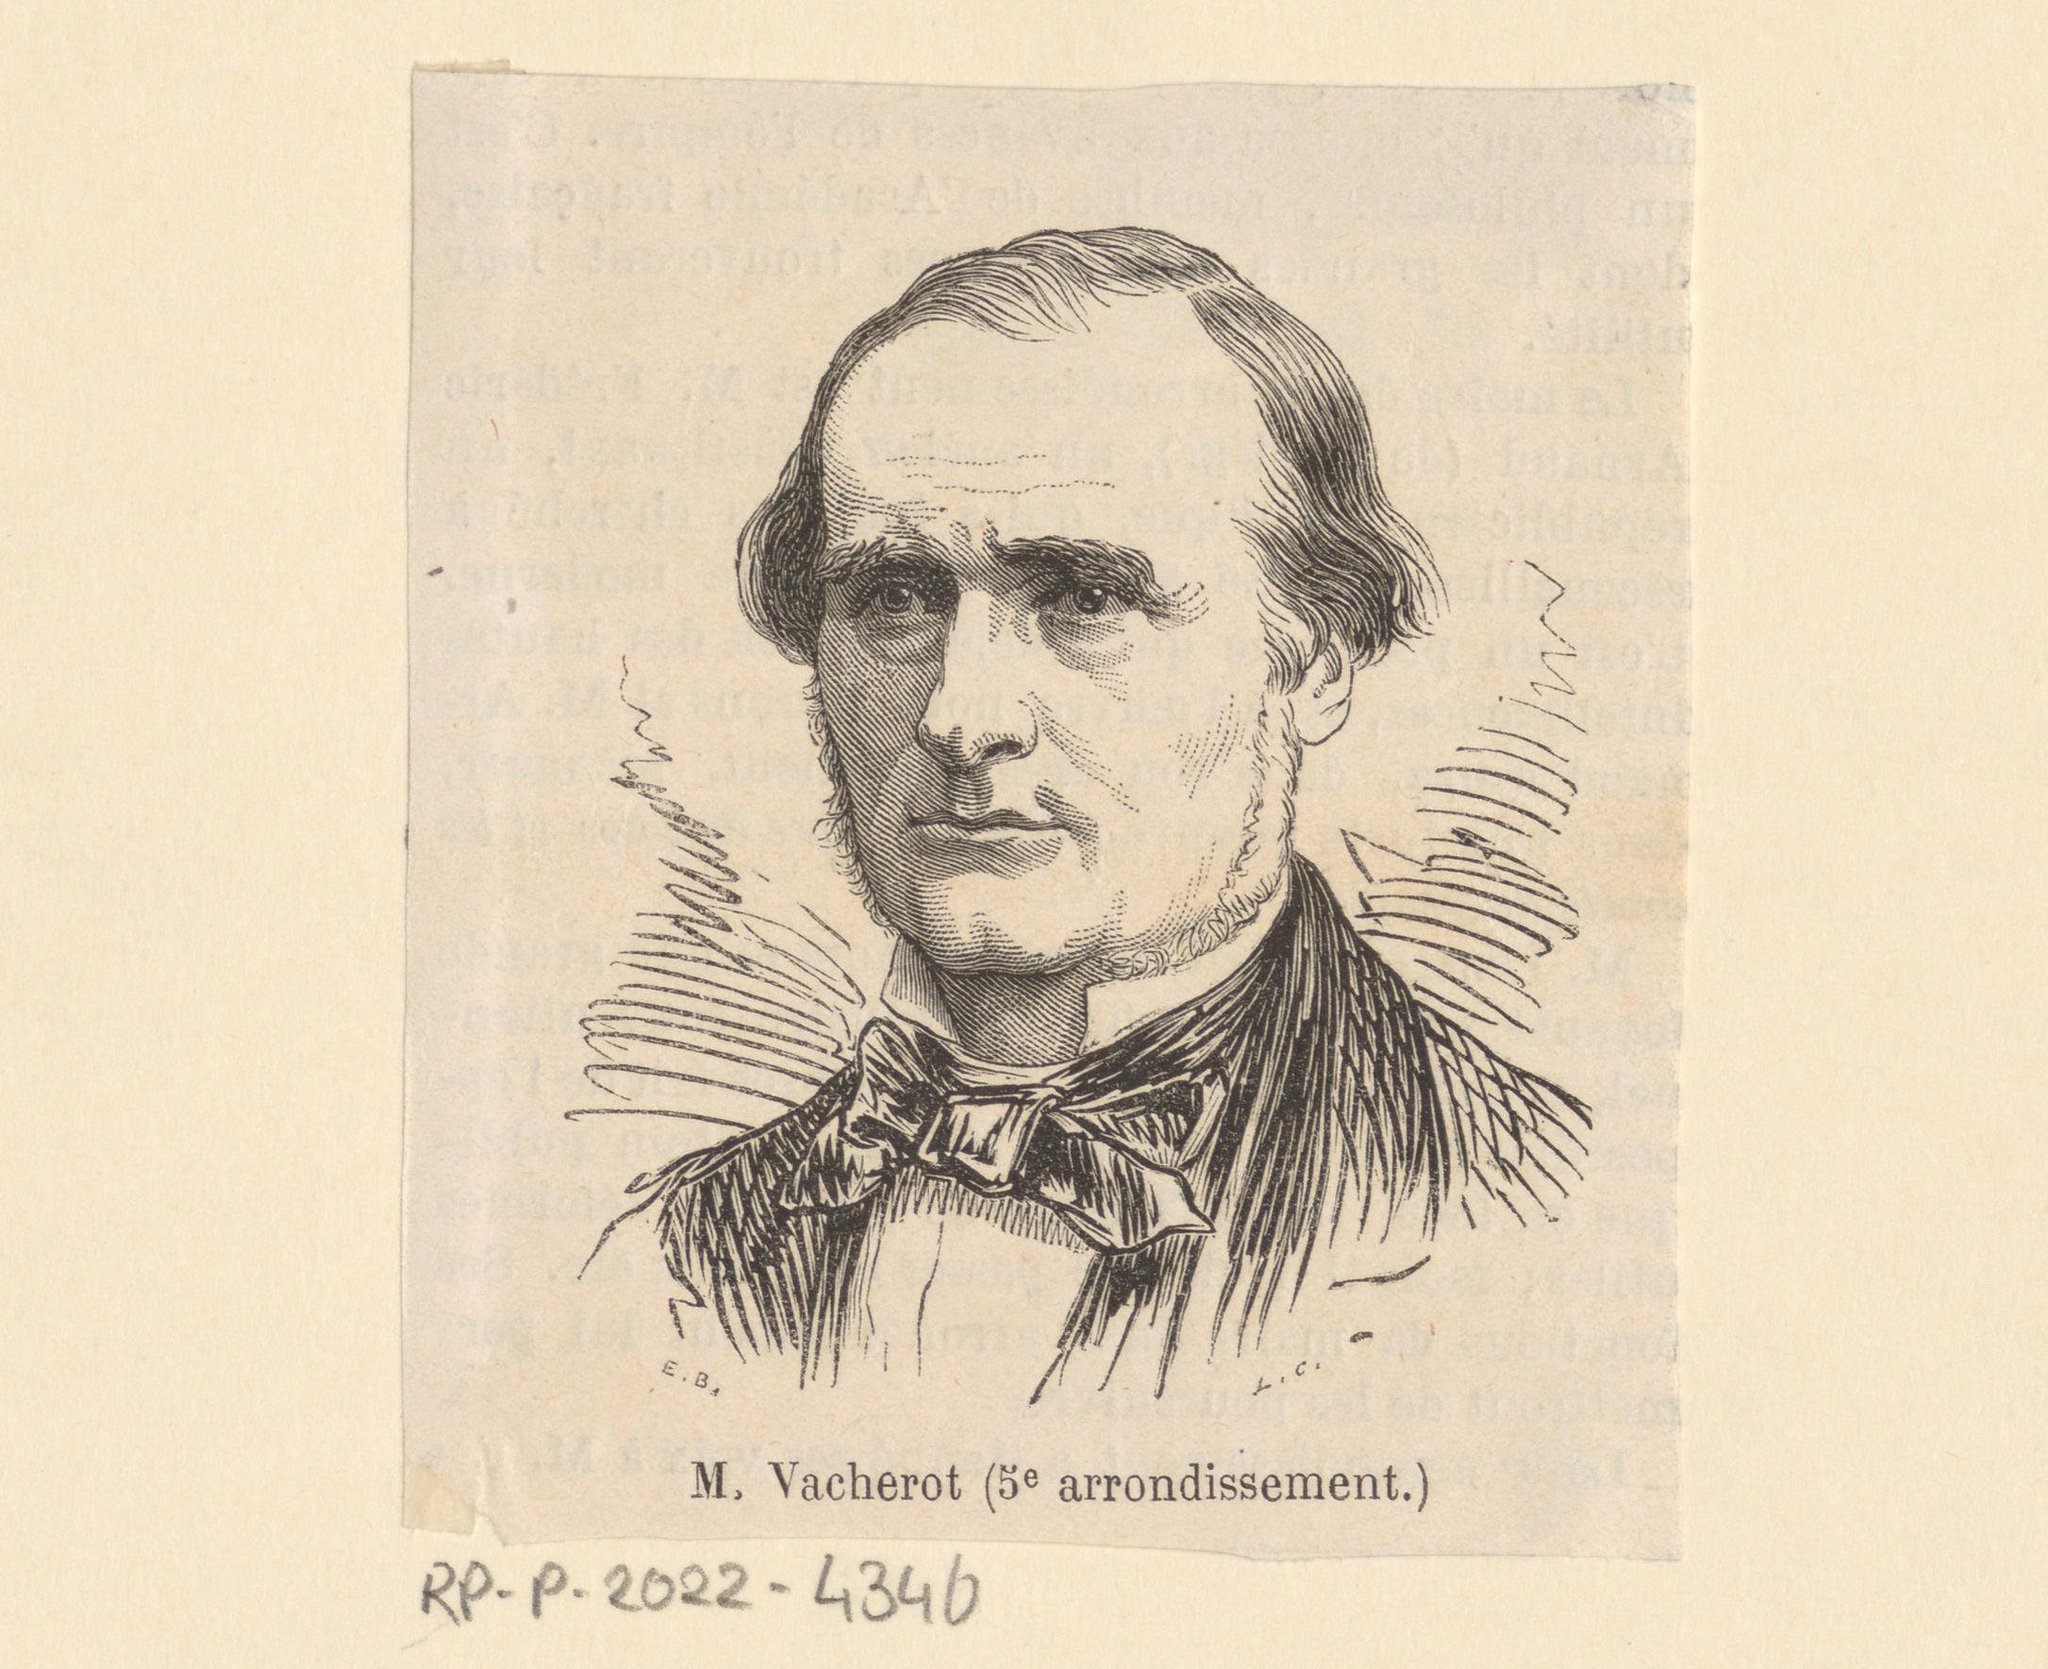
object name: print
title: Portret van Étienne Vacherot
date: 1870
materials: paper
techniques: letterpress printing, engraving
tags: paris, politician, scholar, philosopher, historical persons, portrait of a writer, politician, e.g. party leader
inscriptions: monogram: ‘L.C.’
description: Prent uit: Le monde illustré (1870) dl. 14, p. 325.